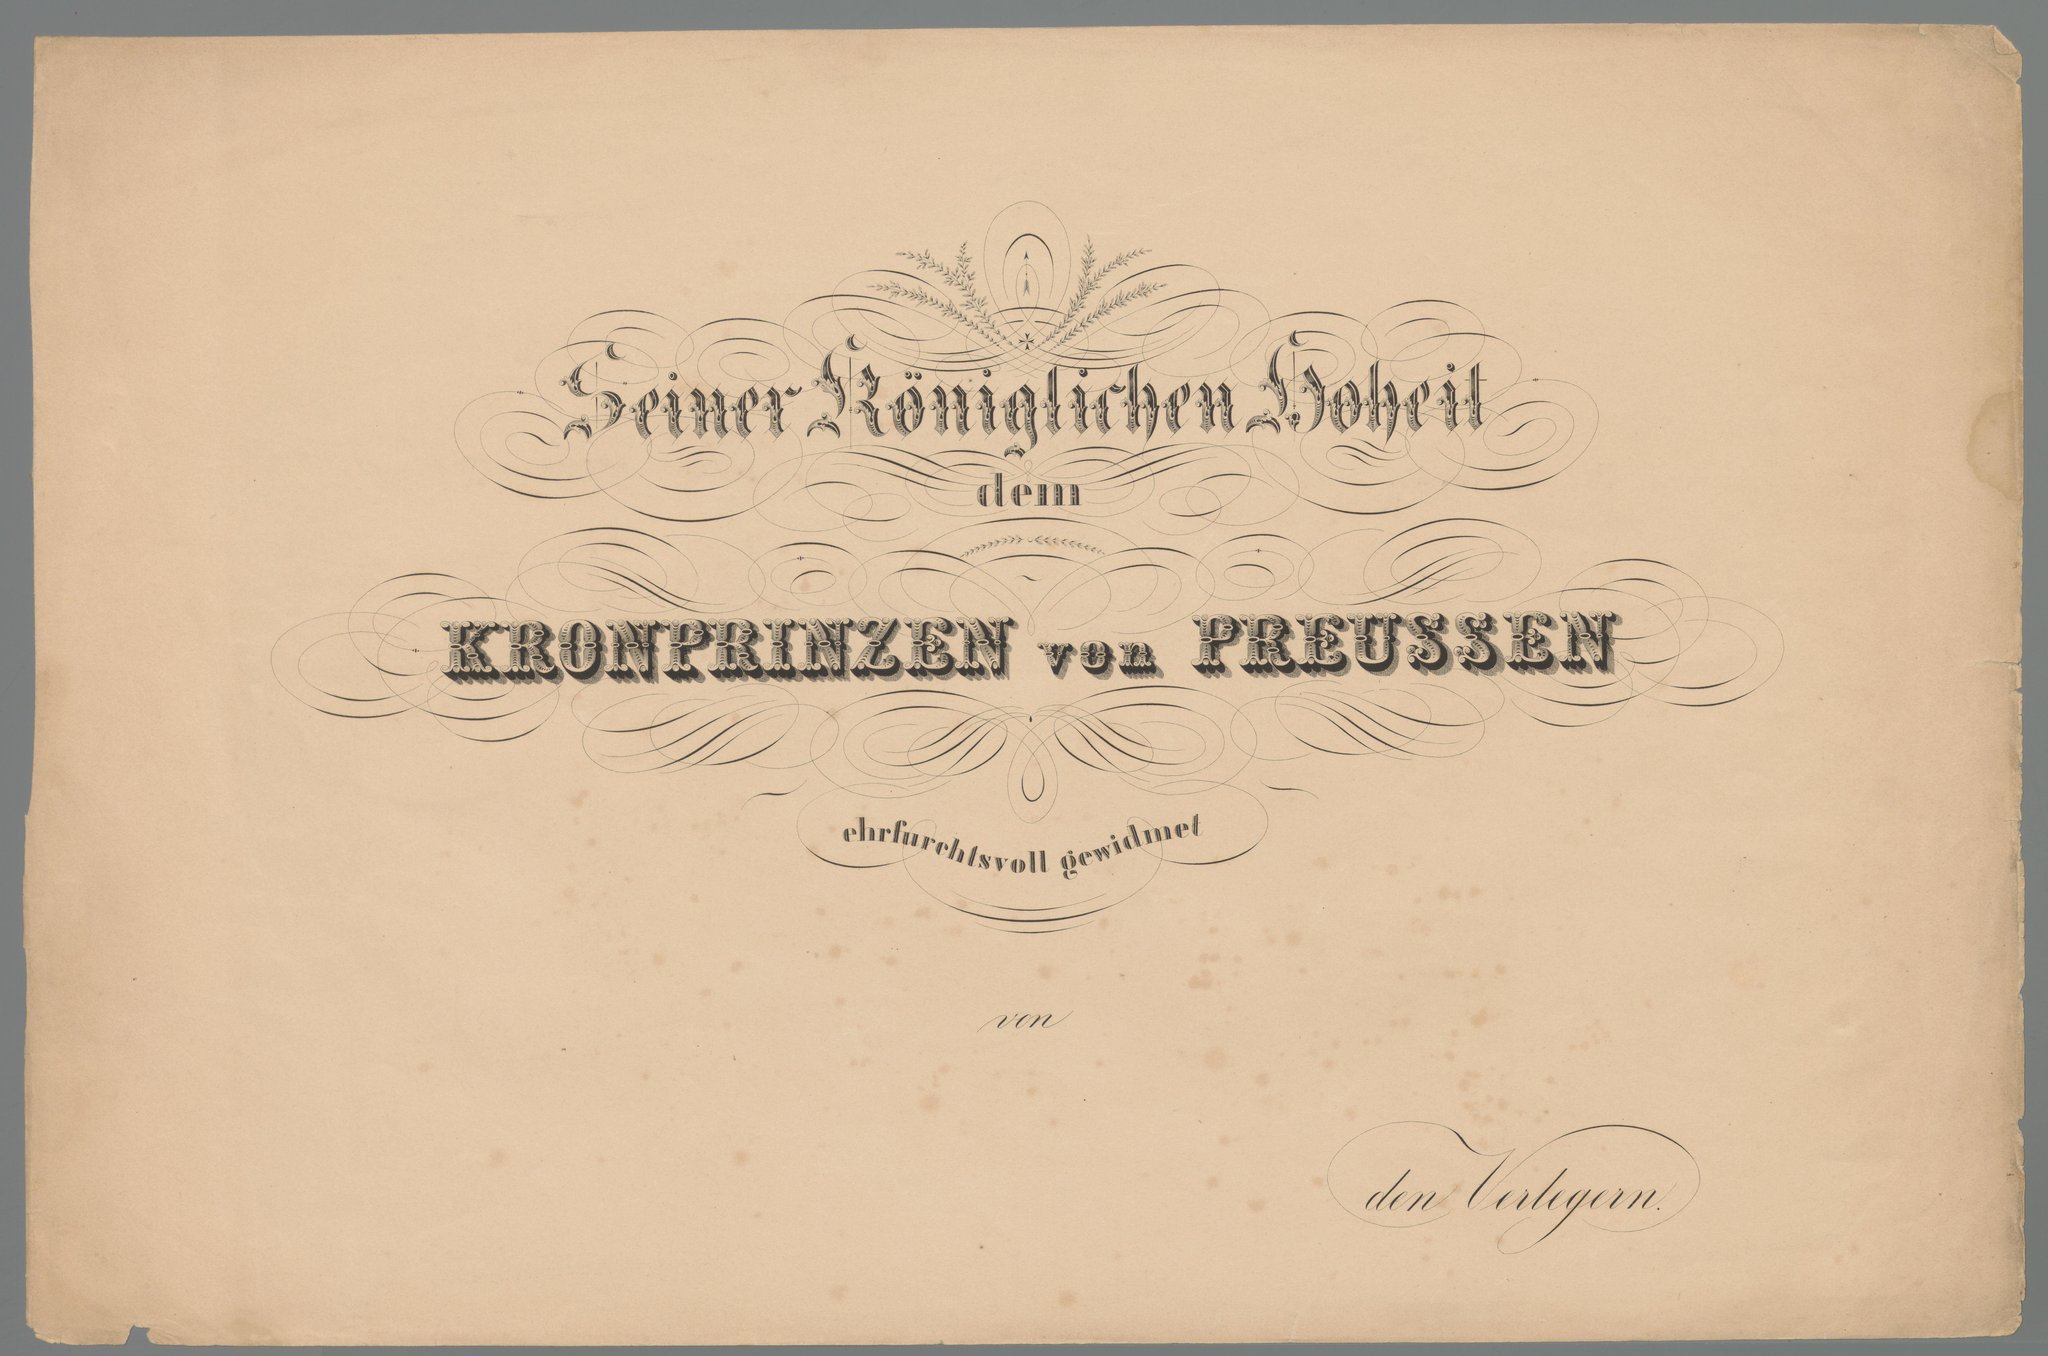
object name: print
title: Das Nahe-Thal. Von dem Ursprunge der Nahe bis zu ihrer Mündung in den Rhein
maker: johann philipp kehr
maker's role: print maker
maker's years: 1800-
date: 1834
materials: paper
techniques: lithograph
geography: cologne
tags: handwriting, written text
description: De serie 'Das Nahe-Thal. Von dem Ursprunge der Nahe bis zu ihrer Mündung in den Rhein' is uitgegeven in vijf delen van elk vier prenten vervaardigd door A. Brandmayer en Andreas Borum. Tien prenten uit deze serie zijn daarnaast waarschijnlijk ook nog samen onder de titel 'Kreuznach und seine Umgebung. Erinnerung an seine Heilquellen und das Nahe-Thal' uitgegeven.